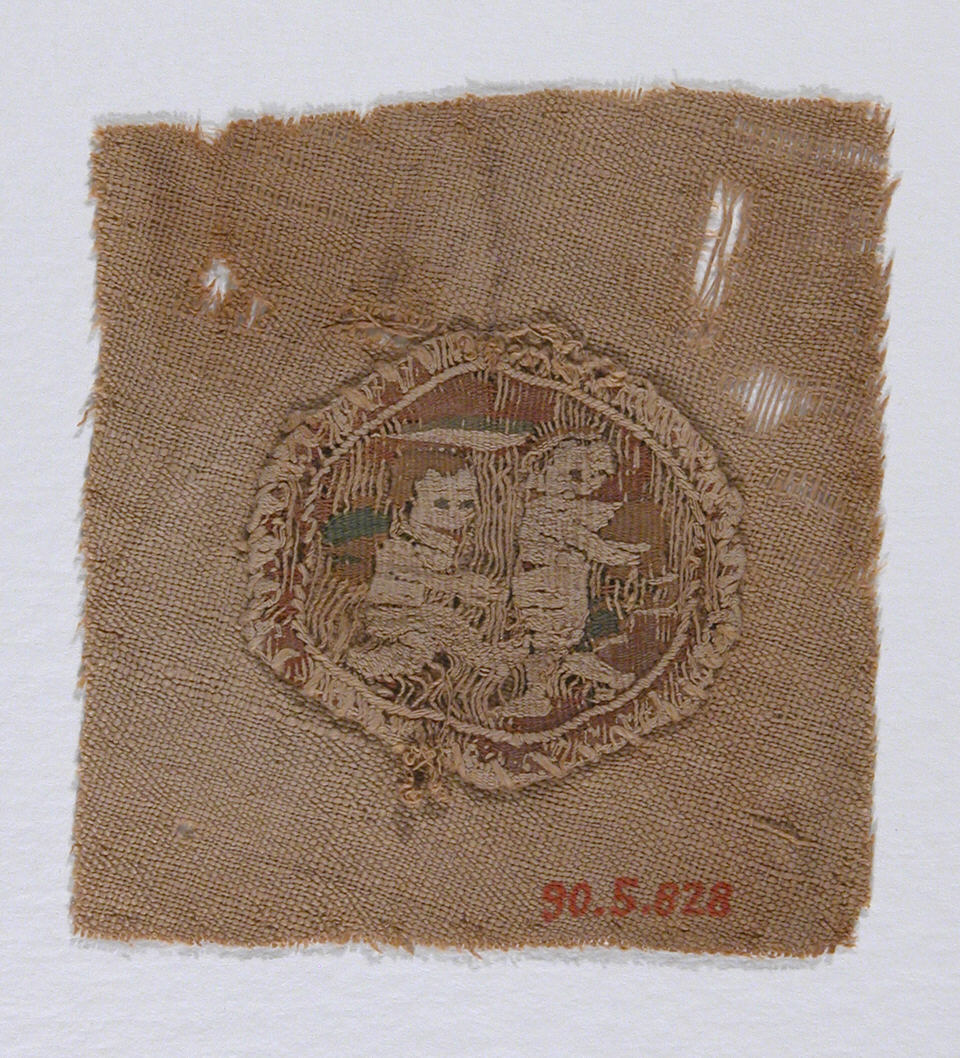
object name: roundel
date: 301-400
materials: linen, wool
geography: egypt